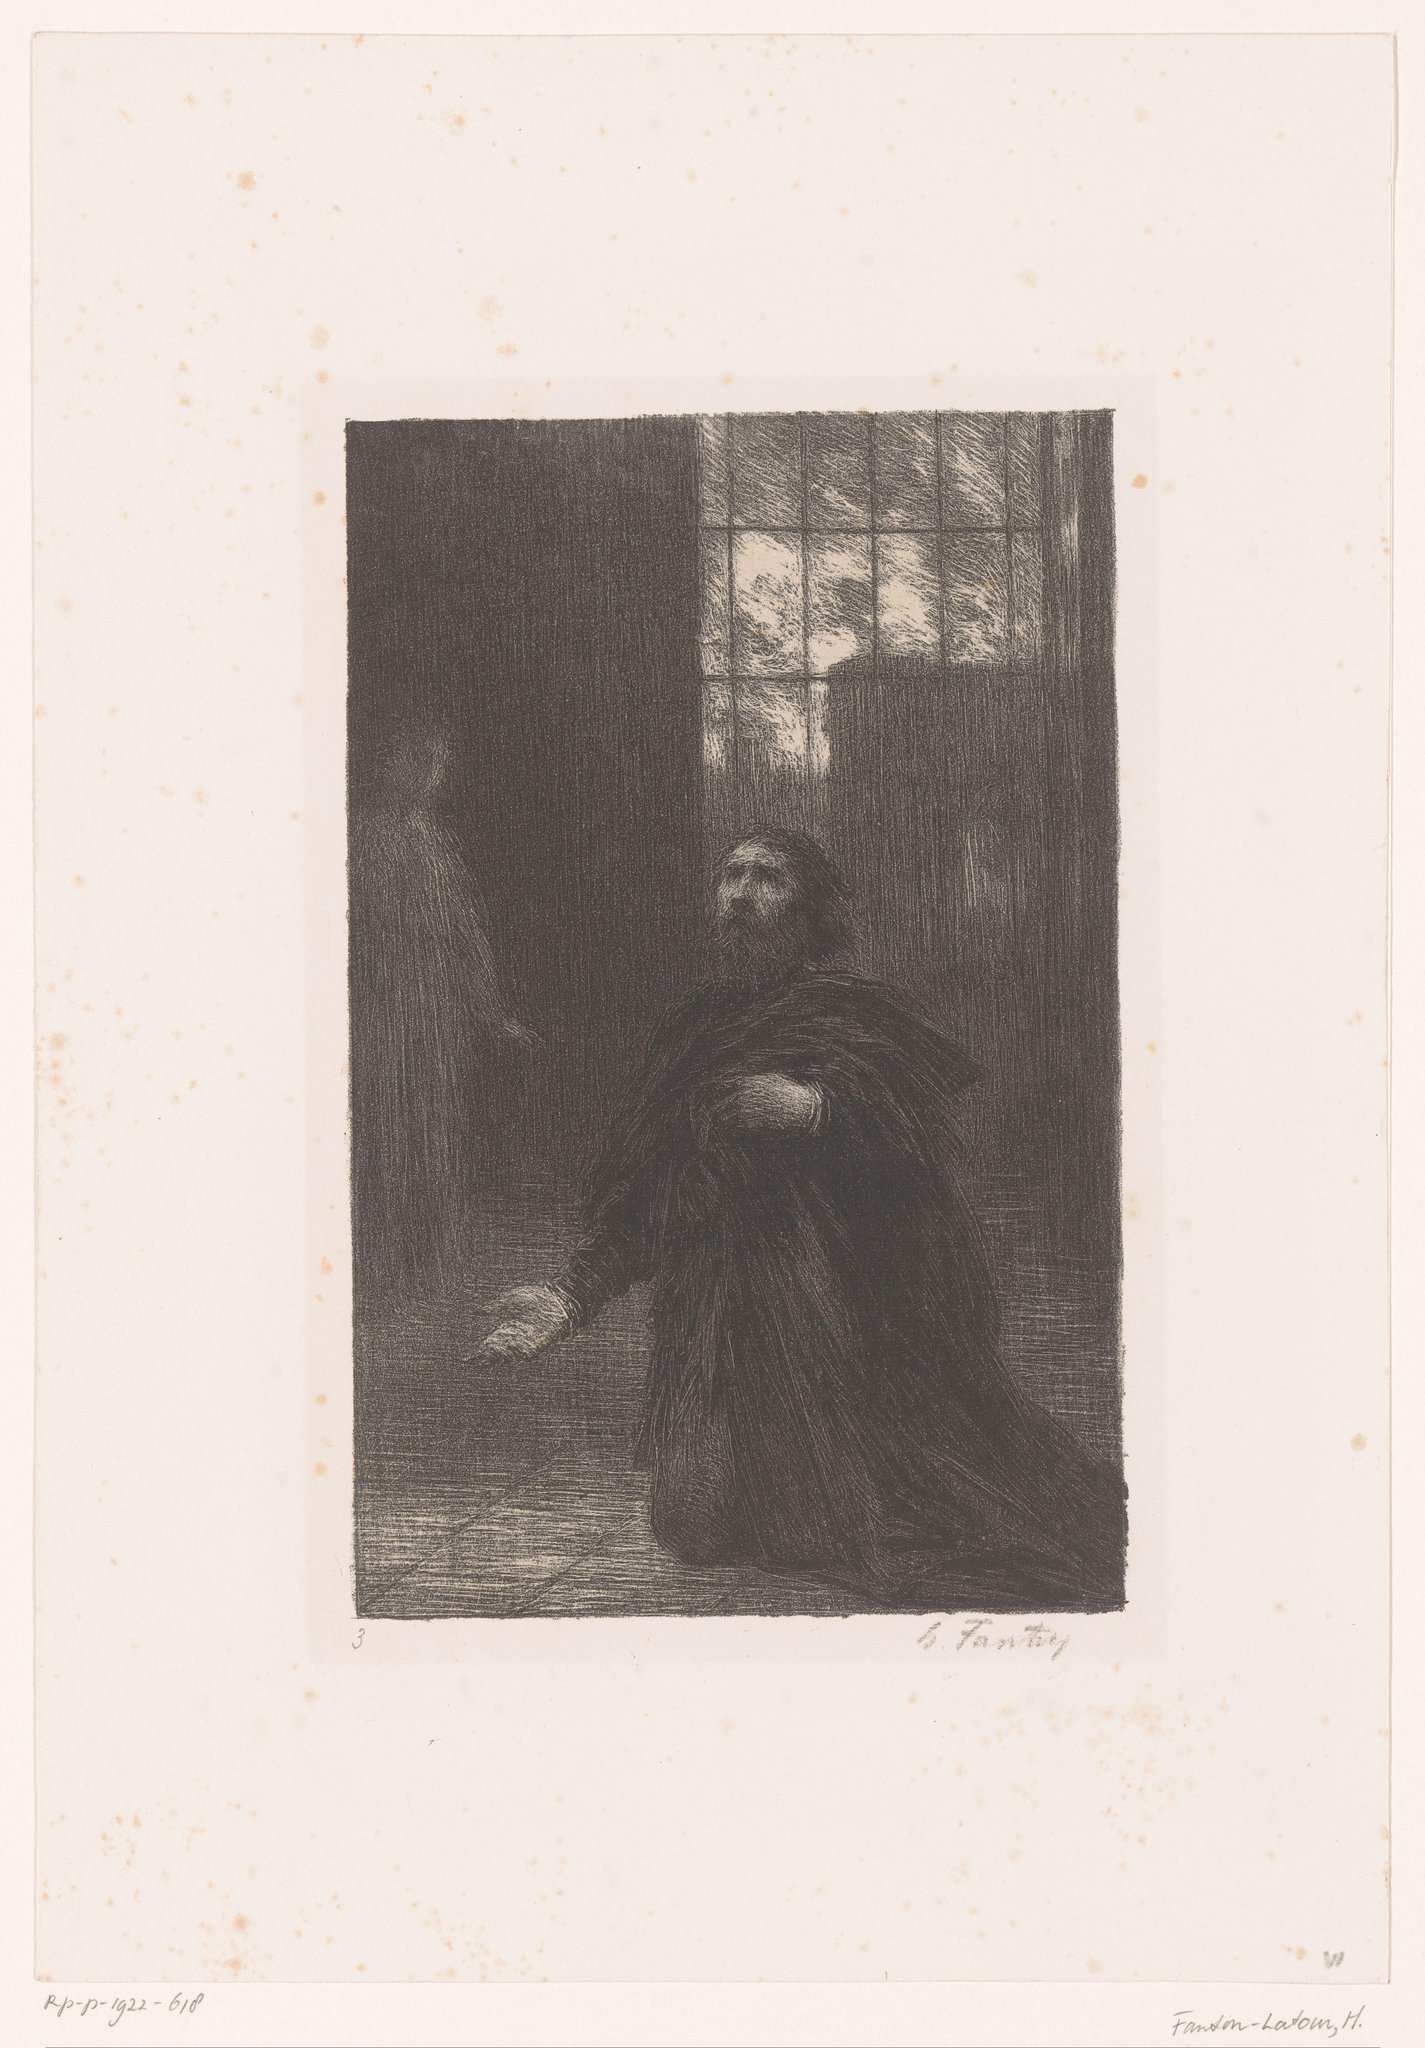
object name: print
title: Leven en werken van Richard Wagner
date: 1886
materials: paper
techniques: lithography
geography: paris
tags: calamity, distress; 'calamità', 'calamità o miseria' (ripa), opera, one person praying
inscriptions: collector's mark: Lugt 2228a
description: Prent gebruikt voor: A. Jullien, Richard Wagner: sa vie et ses œuvres, Parijs 1886. Scène uit Wagners opera Rienzi, der Letzte der Tribunen (akte V).